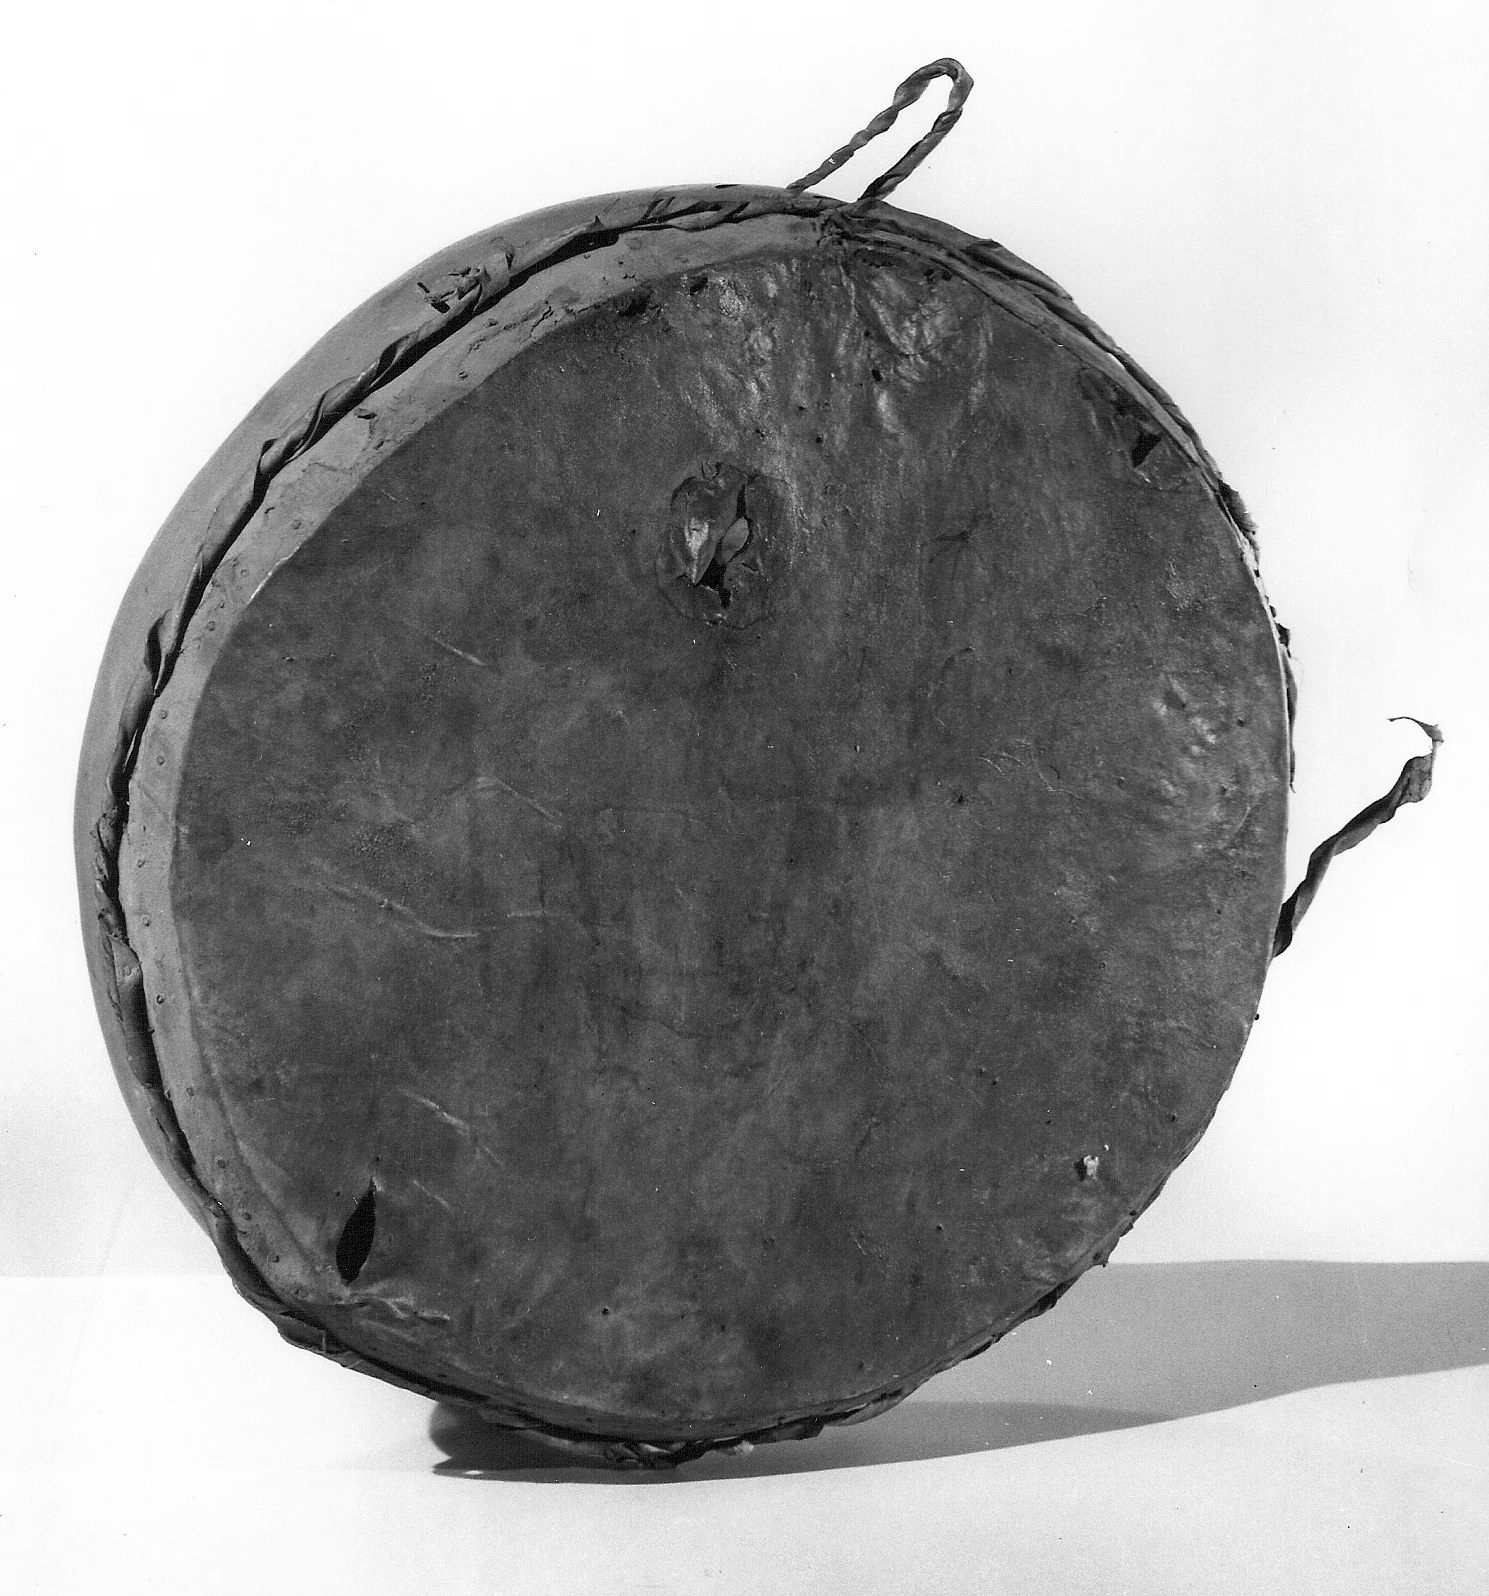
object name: calabash drum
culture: west african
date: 1801-1900